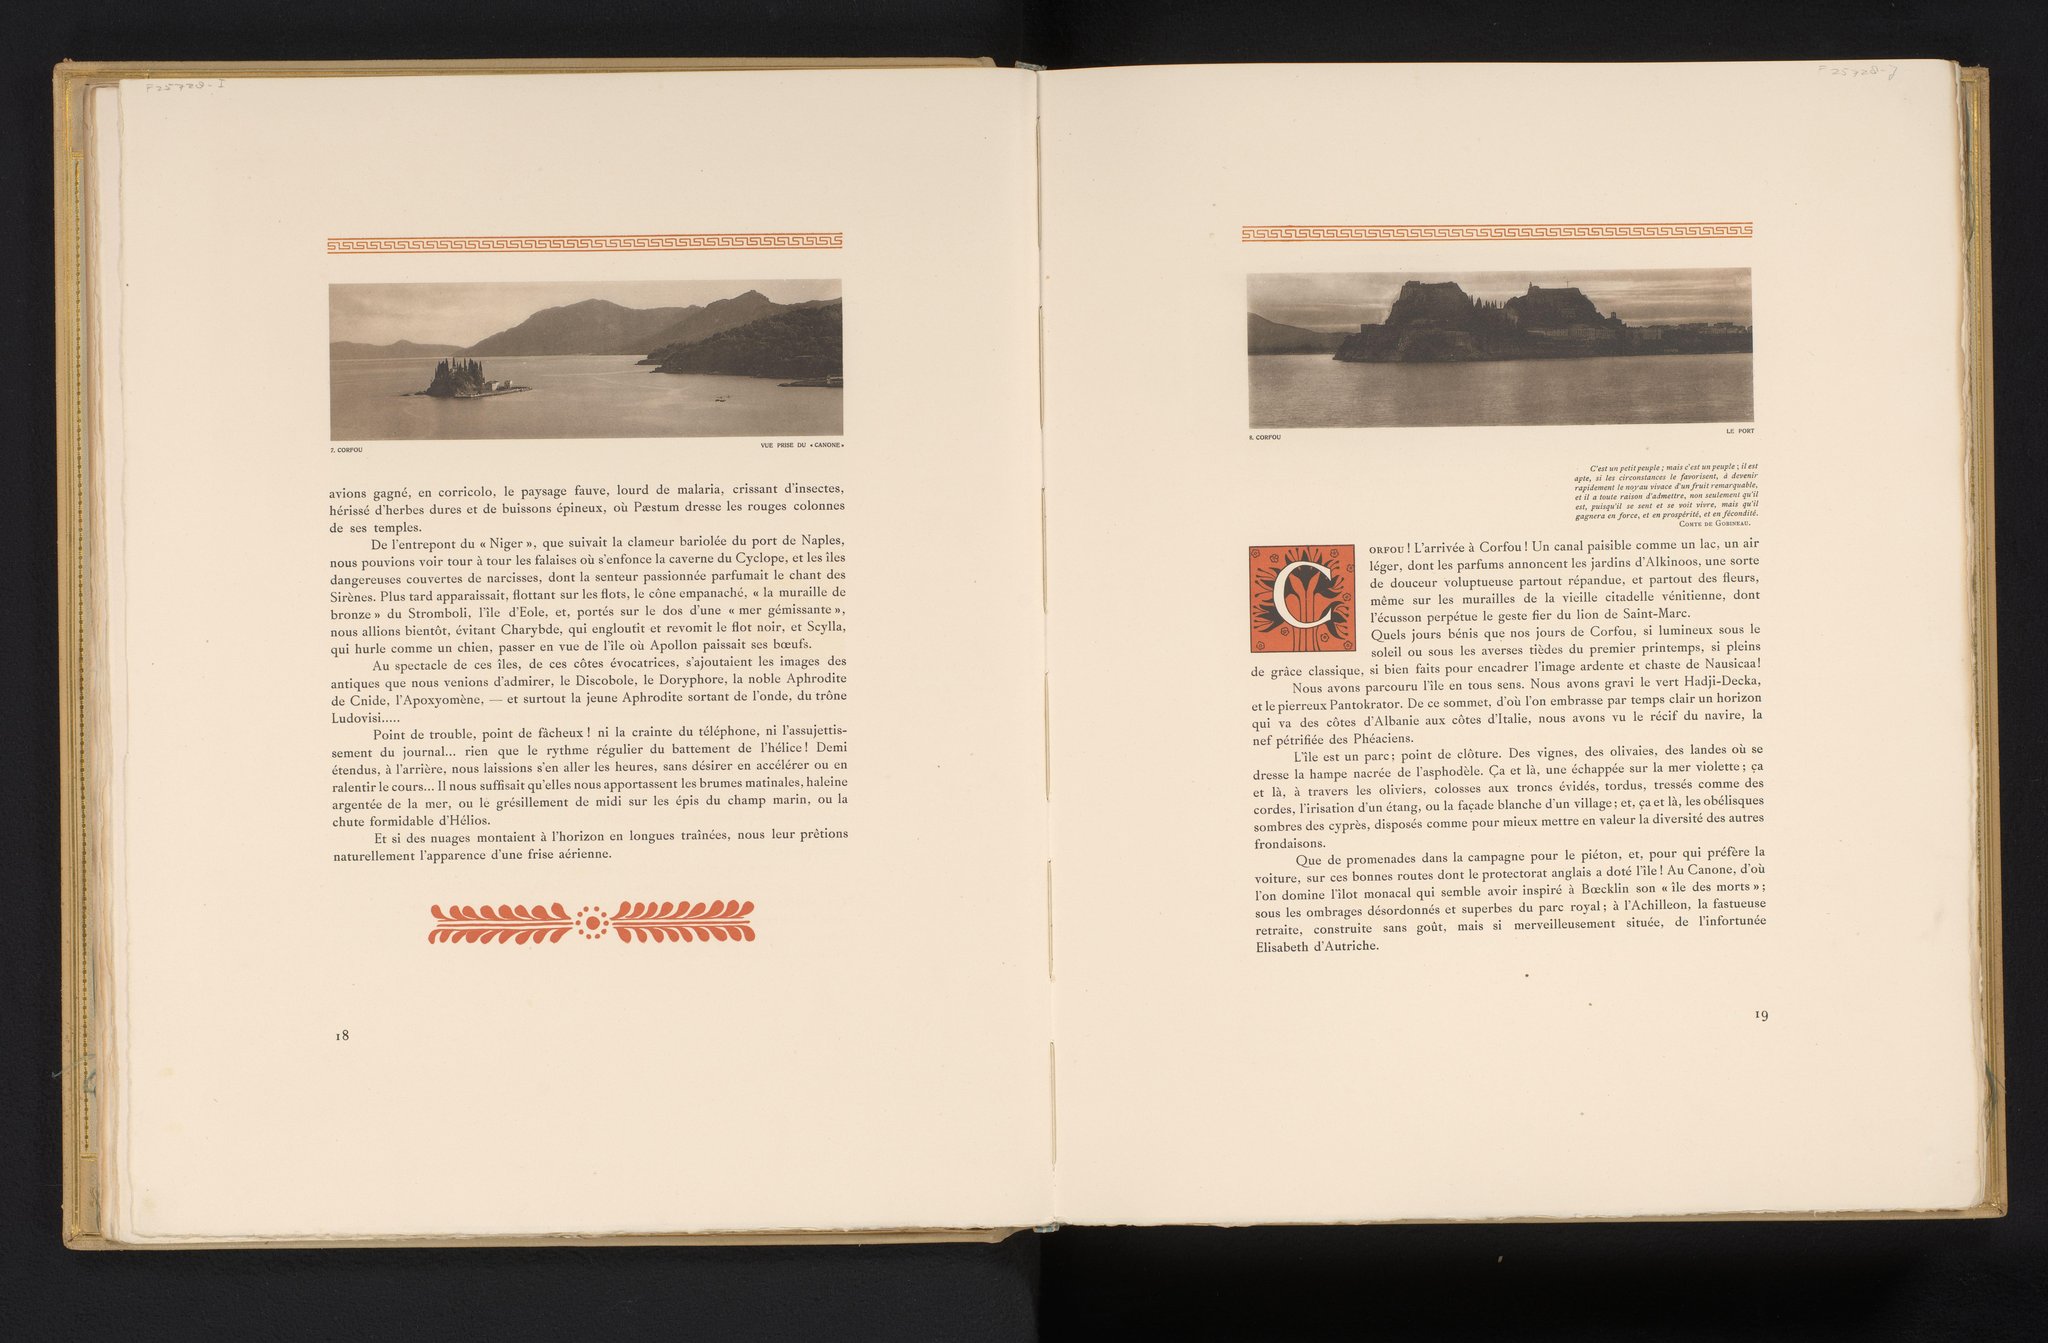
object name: page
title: Haven van Korfoe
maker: frédéric boissonnas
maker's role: fotograaf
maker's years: 1858-1946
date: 1905-1910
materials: paper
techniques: photograph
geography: corfu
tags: harbour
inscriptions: number: ‘8.’